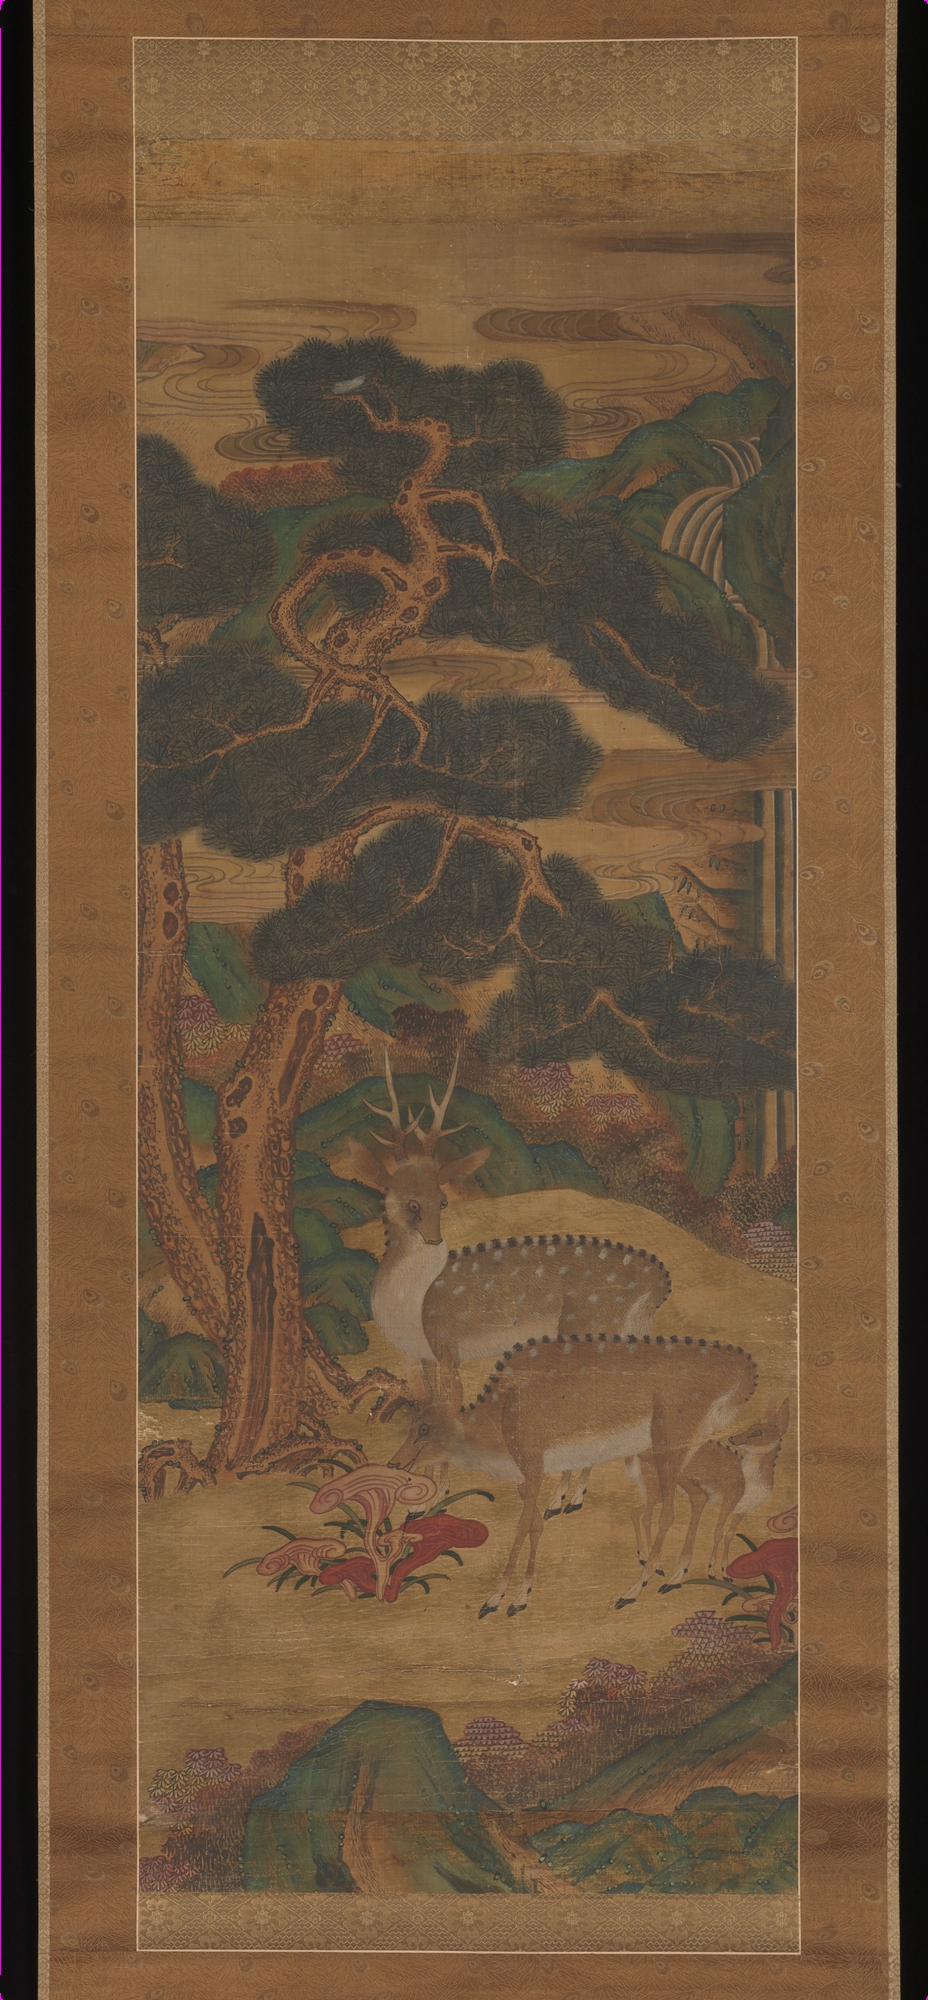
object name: hanging scroll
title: Deer amid Pine Trees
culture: korean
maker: unidentified artist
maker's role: artist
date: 1801-1900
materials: ink, silk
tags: deer,trees